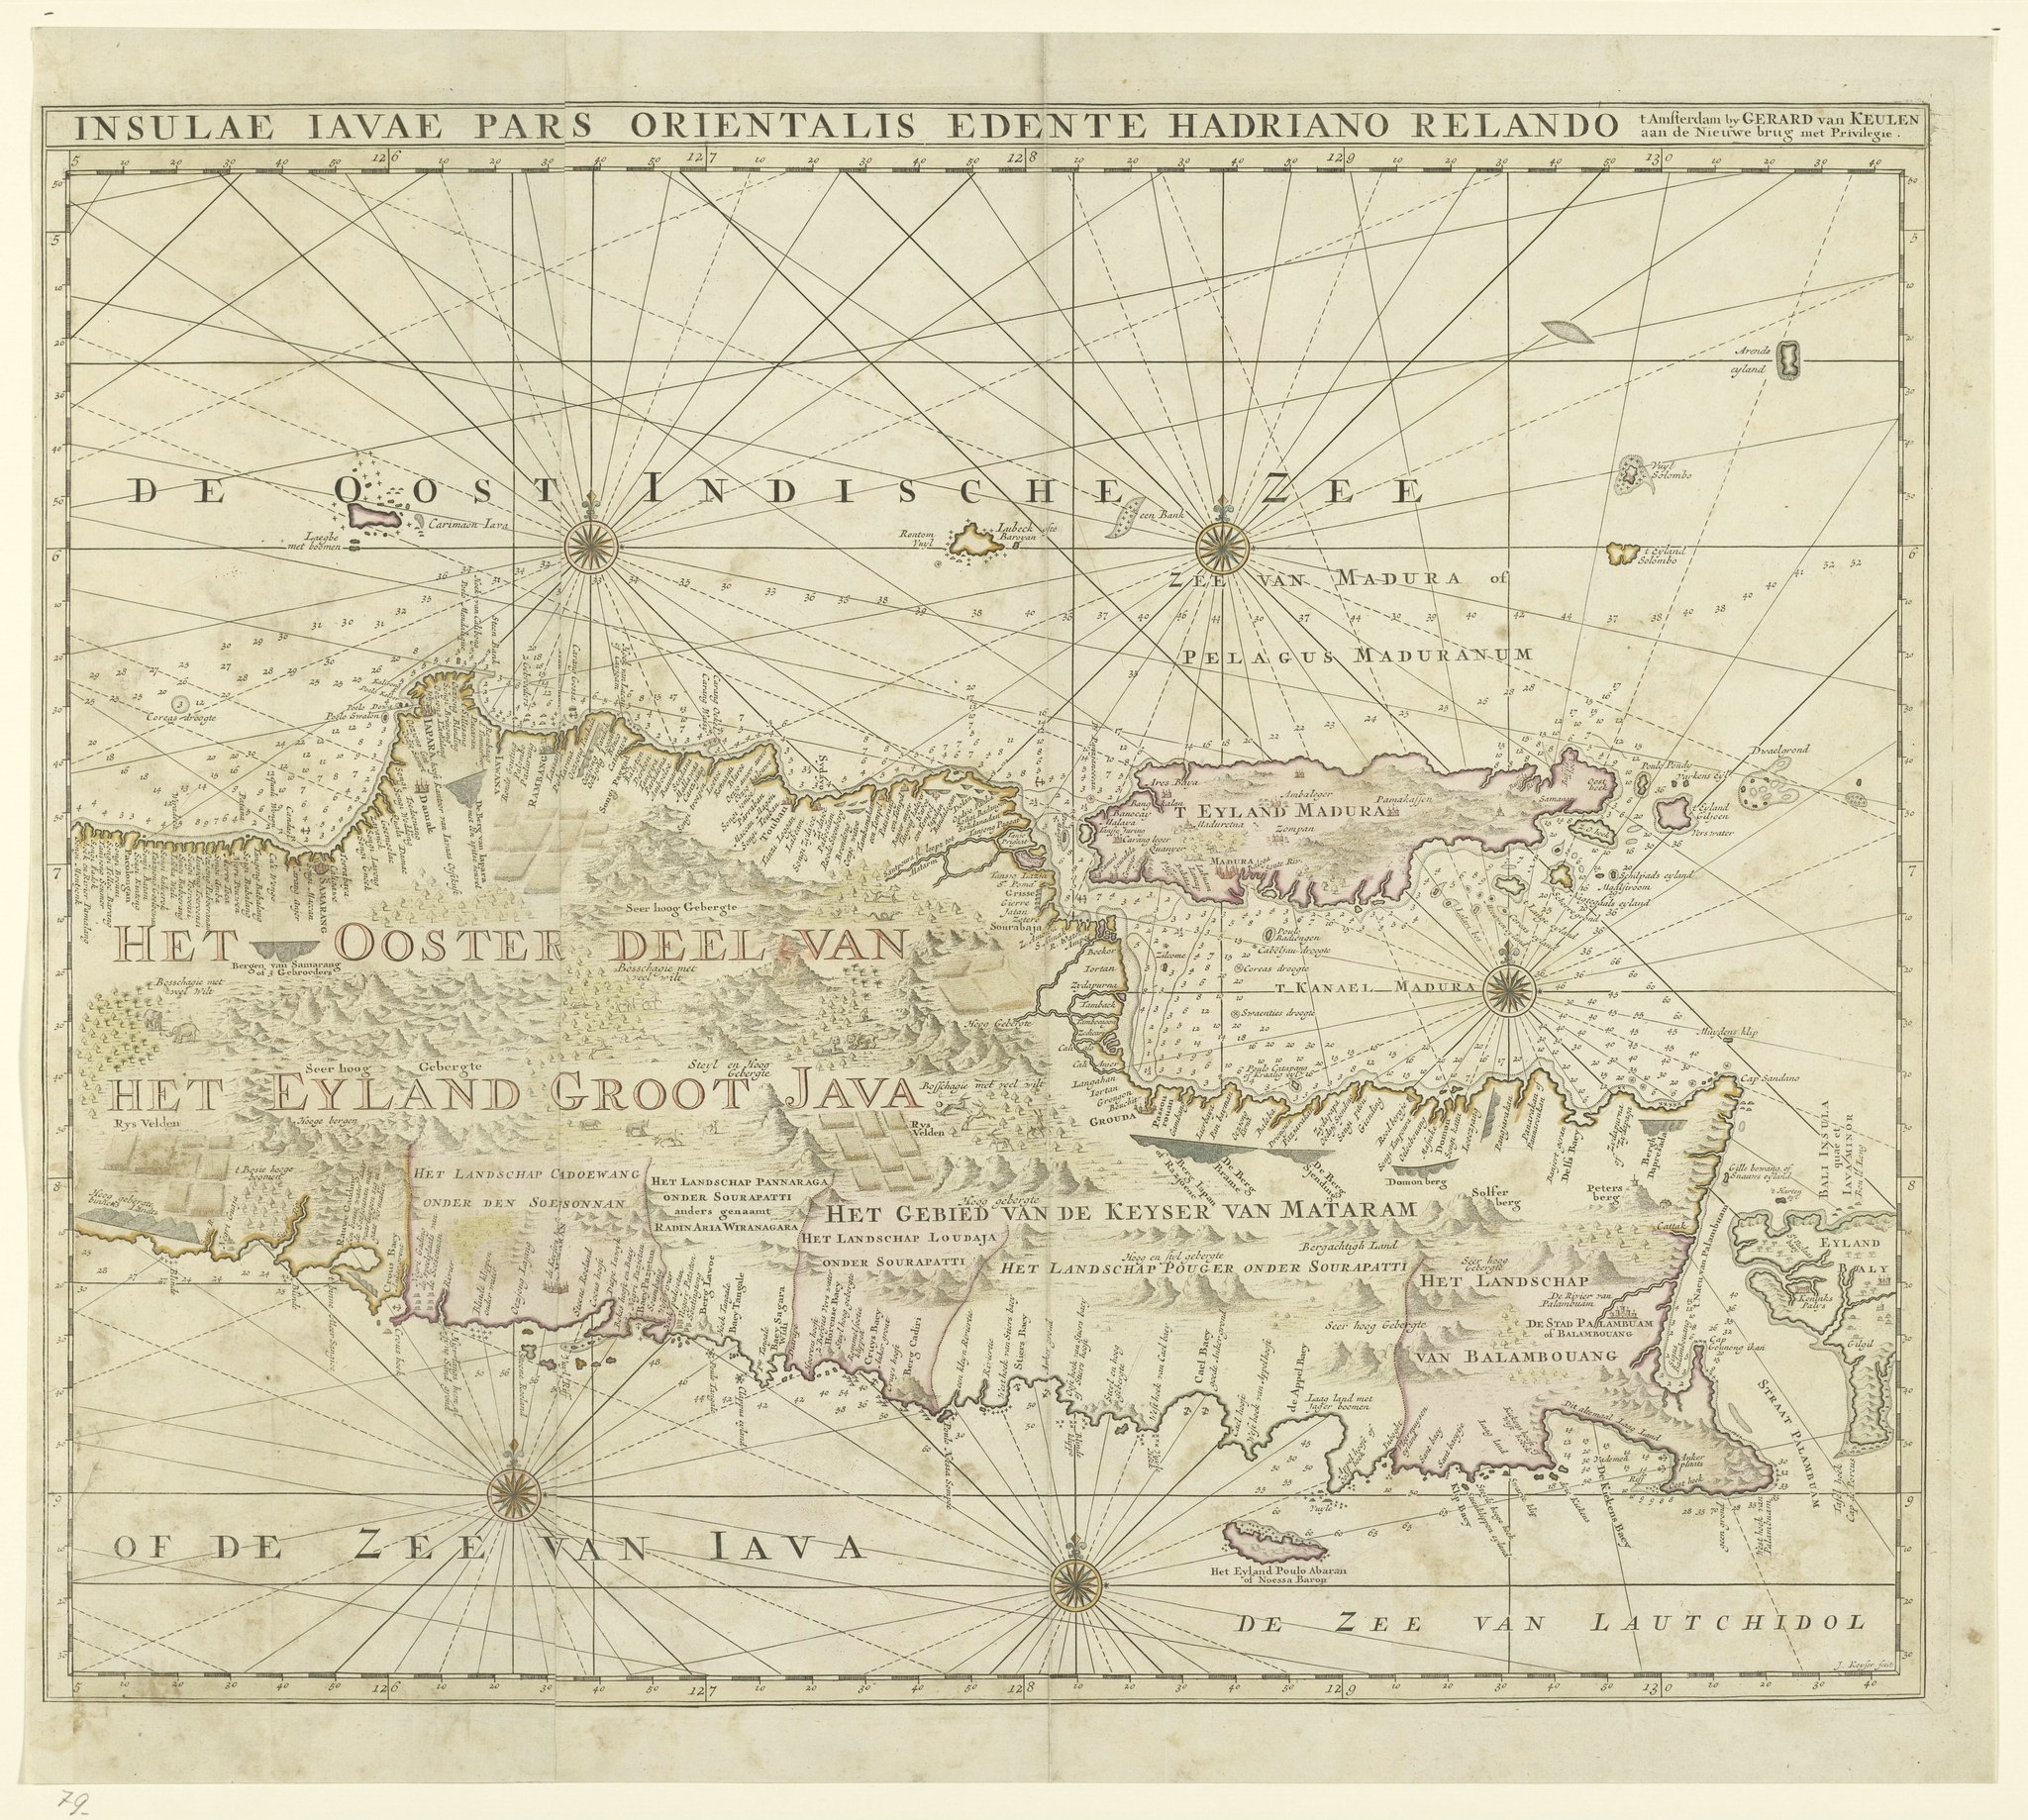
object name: print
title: Kaart van het oostelijk deel van Java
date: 1728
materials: paper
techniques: engraving, hand coloring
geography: amsterdam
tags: maps of separate countries or regions, java, madura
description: Kaart van Oost Java. Bovenaan een gezicht op Batavia vanaf het water. Er zijn vijf windrozen en op de kaart zijn topografische bijzonderheden aangebracht: rijstvelden, bergen, wilde dieren etc. Met het eiland Madura. Voor de schaal zie de linkerhelft. Rechterhelft van een kaart van het gehele eiland Java.